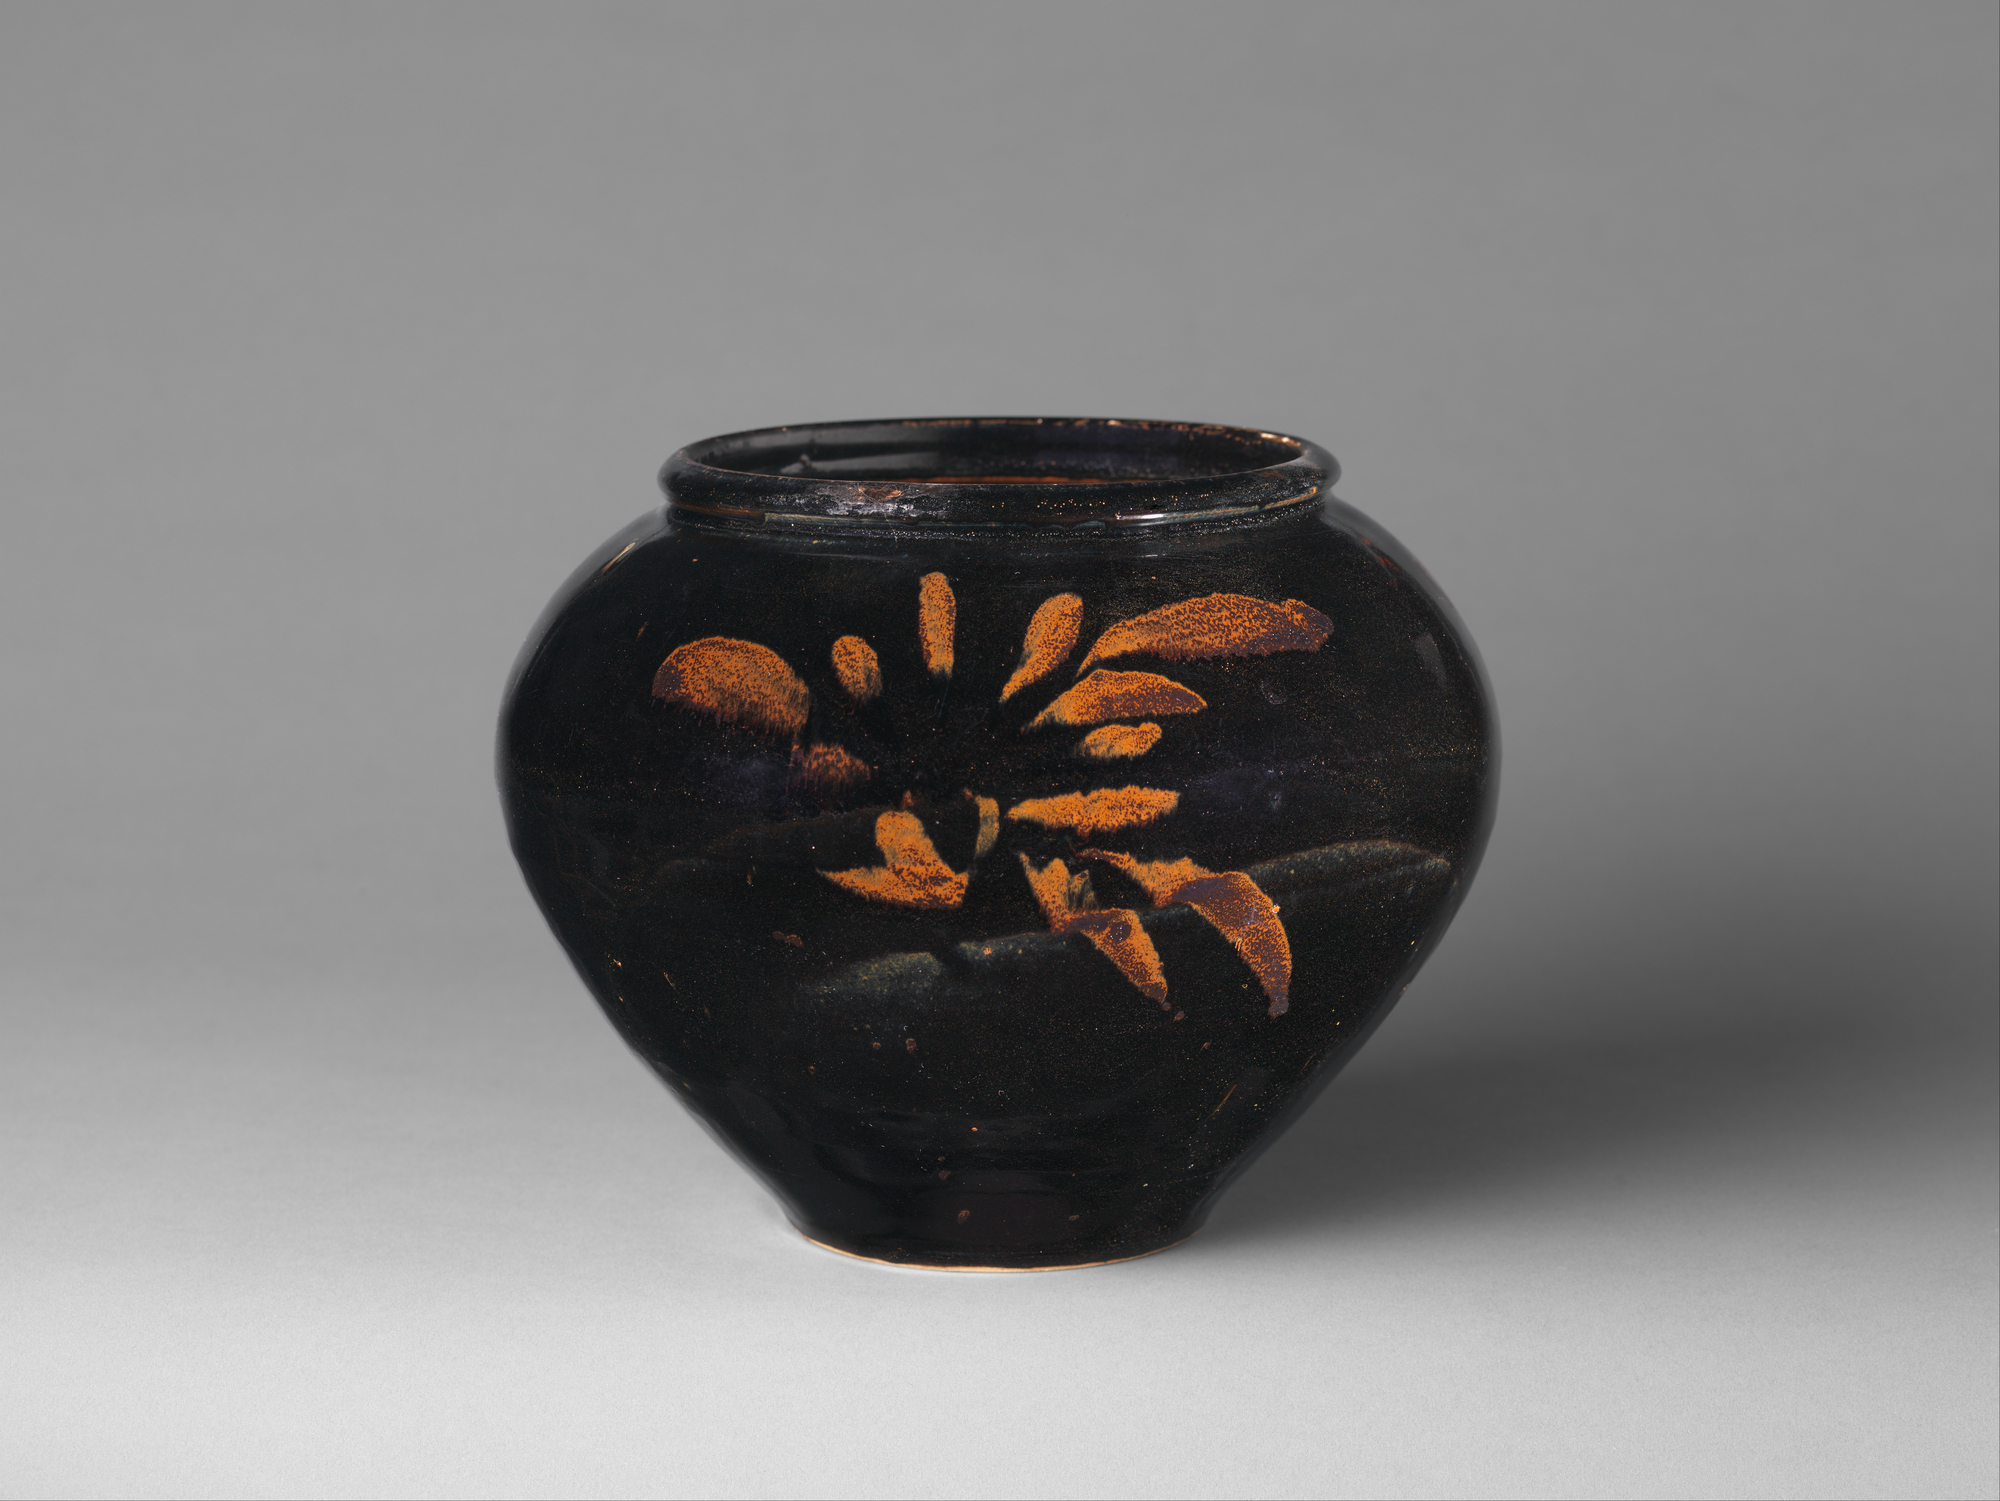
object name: jar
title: Jar with Abstract Decoration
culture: chinese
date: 1167-1233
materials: glaze, iron, stoneware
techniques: painting